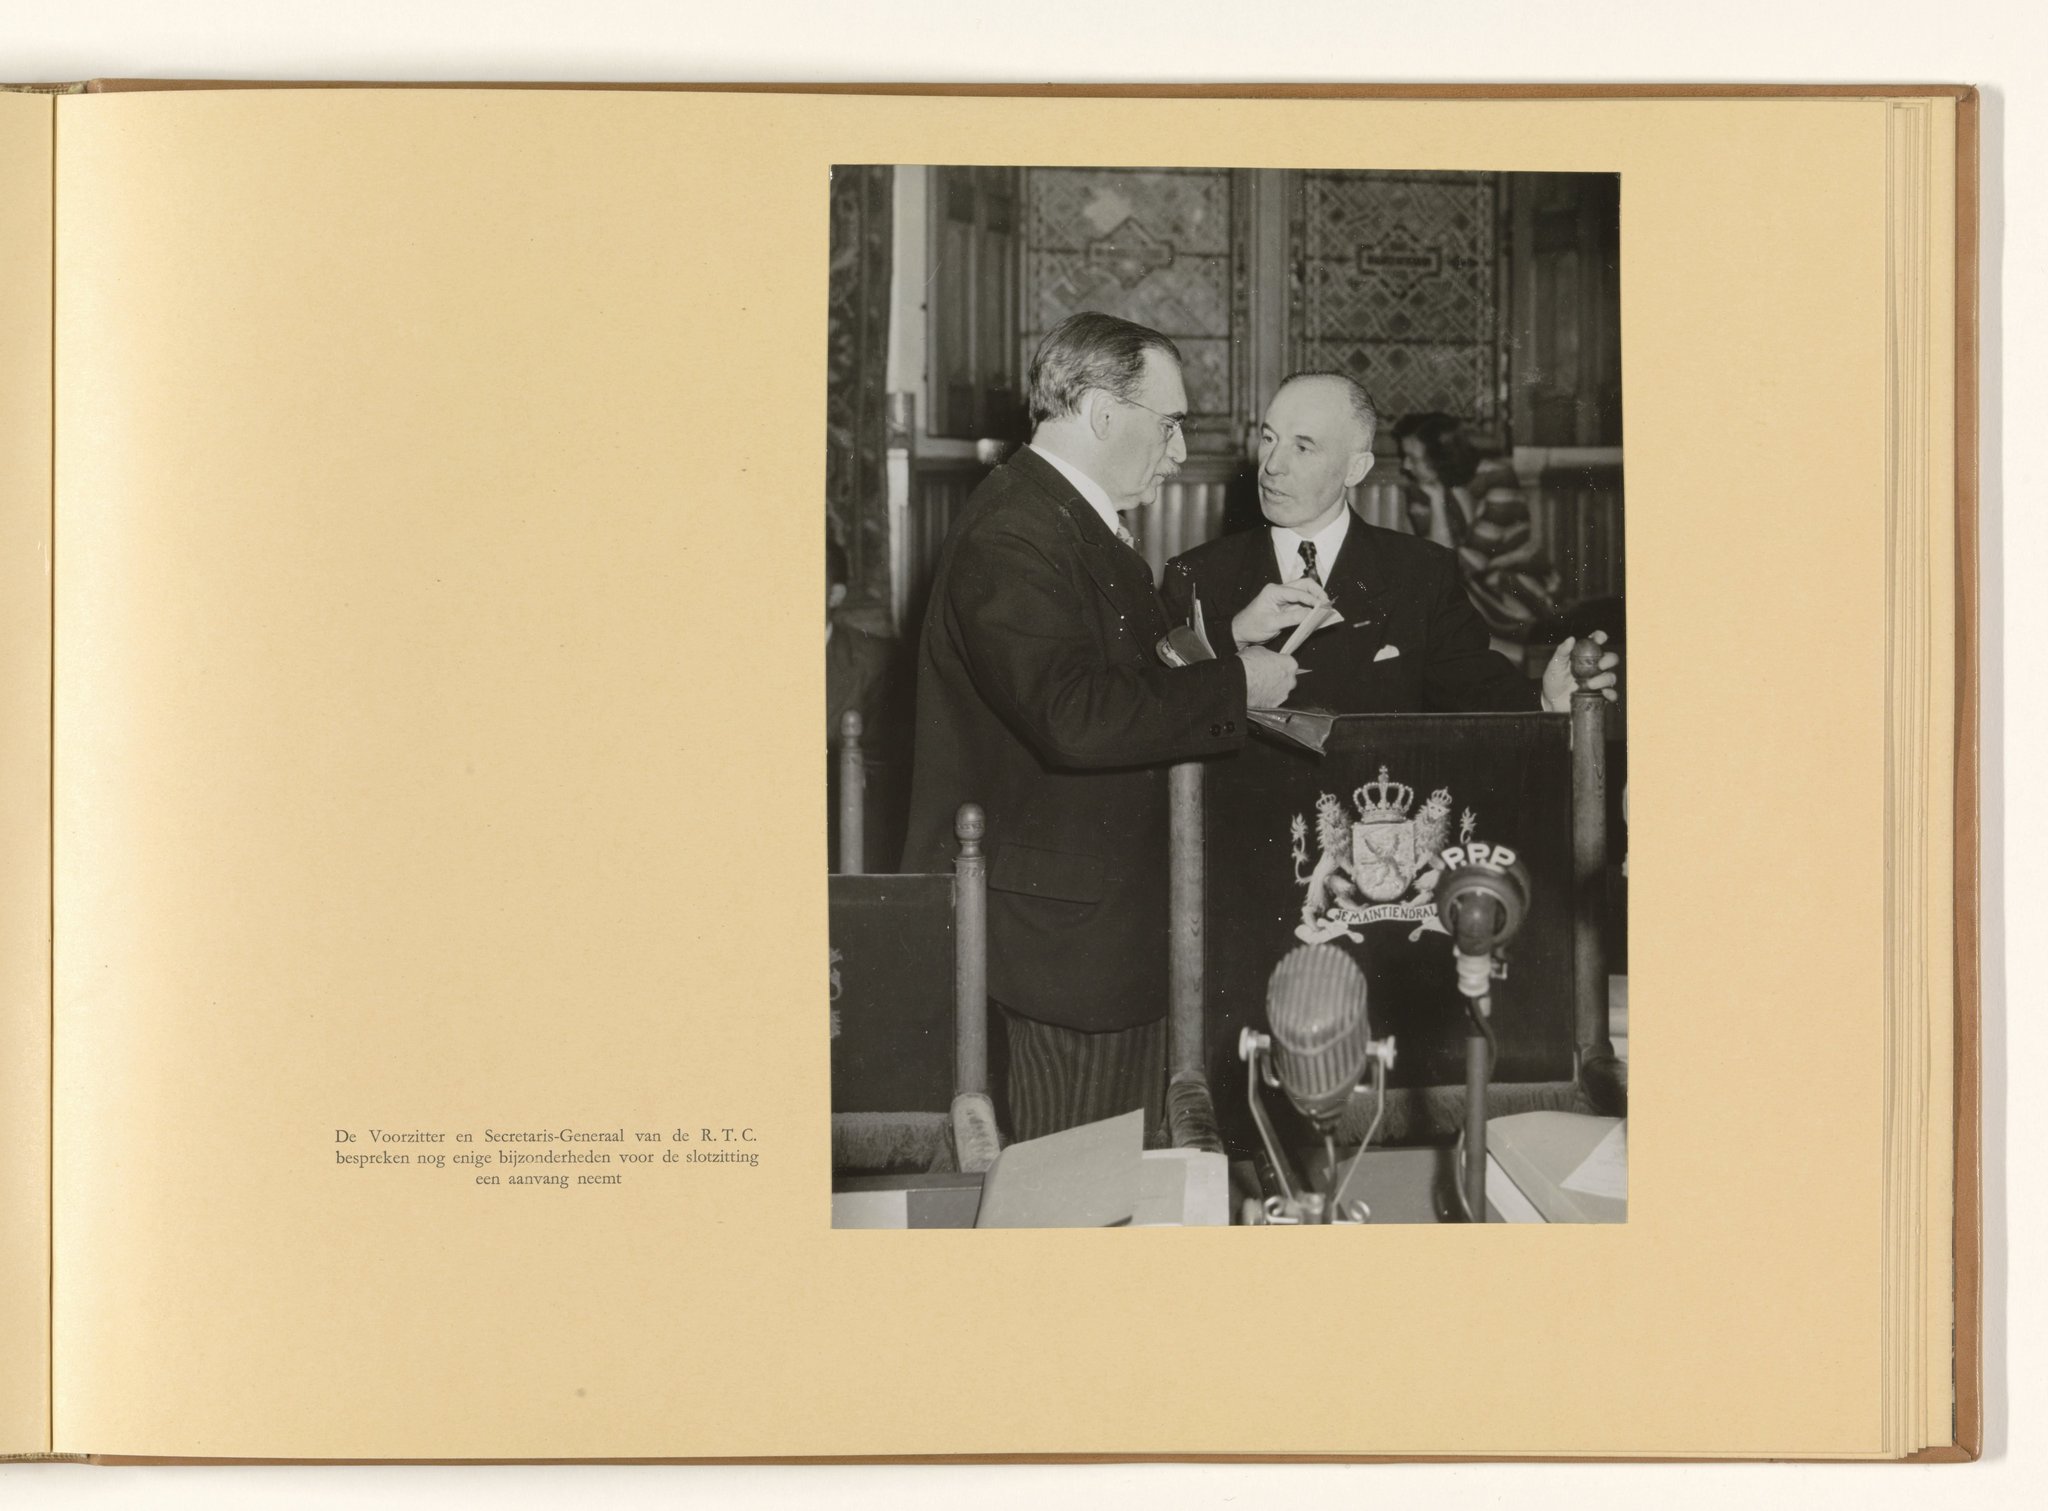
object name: photograph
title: De Voorzitter en Secretaris-Generaal van de R.T.C. bespreken nog enige bijzonderheden voor de slotzitting een aanvang neemt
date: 1949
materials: paper, photographic support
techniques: gelatin silver print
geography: the hague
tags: haarlem, amsterdam, the hague, willem drees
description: Premier Drees en secretaris-generaal Max Prinsen in gesprek vóór aanvang van de slotzitting van de conferentie op 2 november 1949. Foto in het fotoalbum met 37 foto's van de rondetafelconferentie gehouden tussen 23 augustus en 2 november in Den Haag in 1949 tussen vertegenwoordigers van Nederland, de Republiek Indonesië en de Bijeenkomst Federaal Overleg. Het exemplaar aangeboden aan premier Willem Drees.